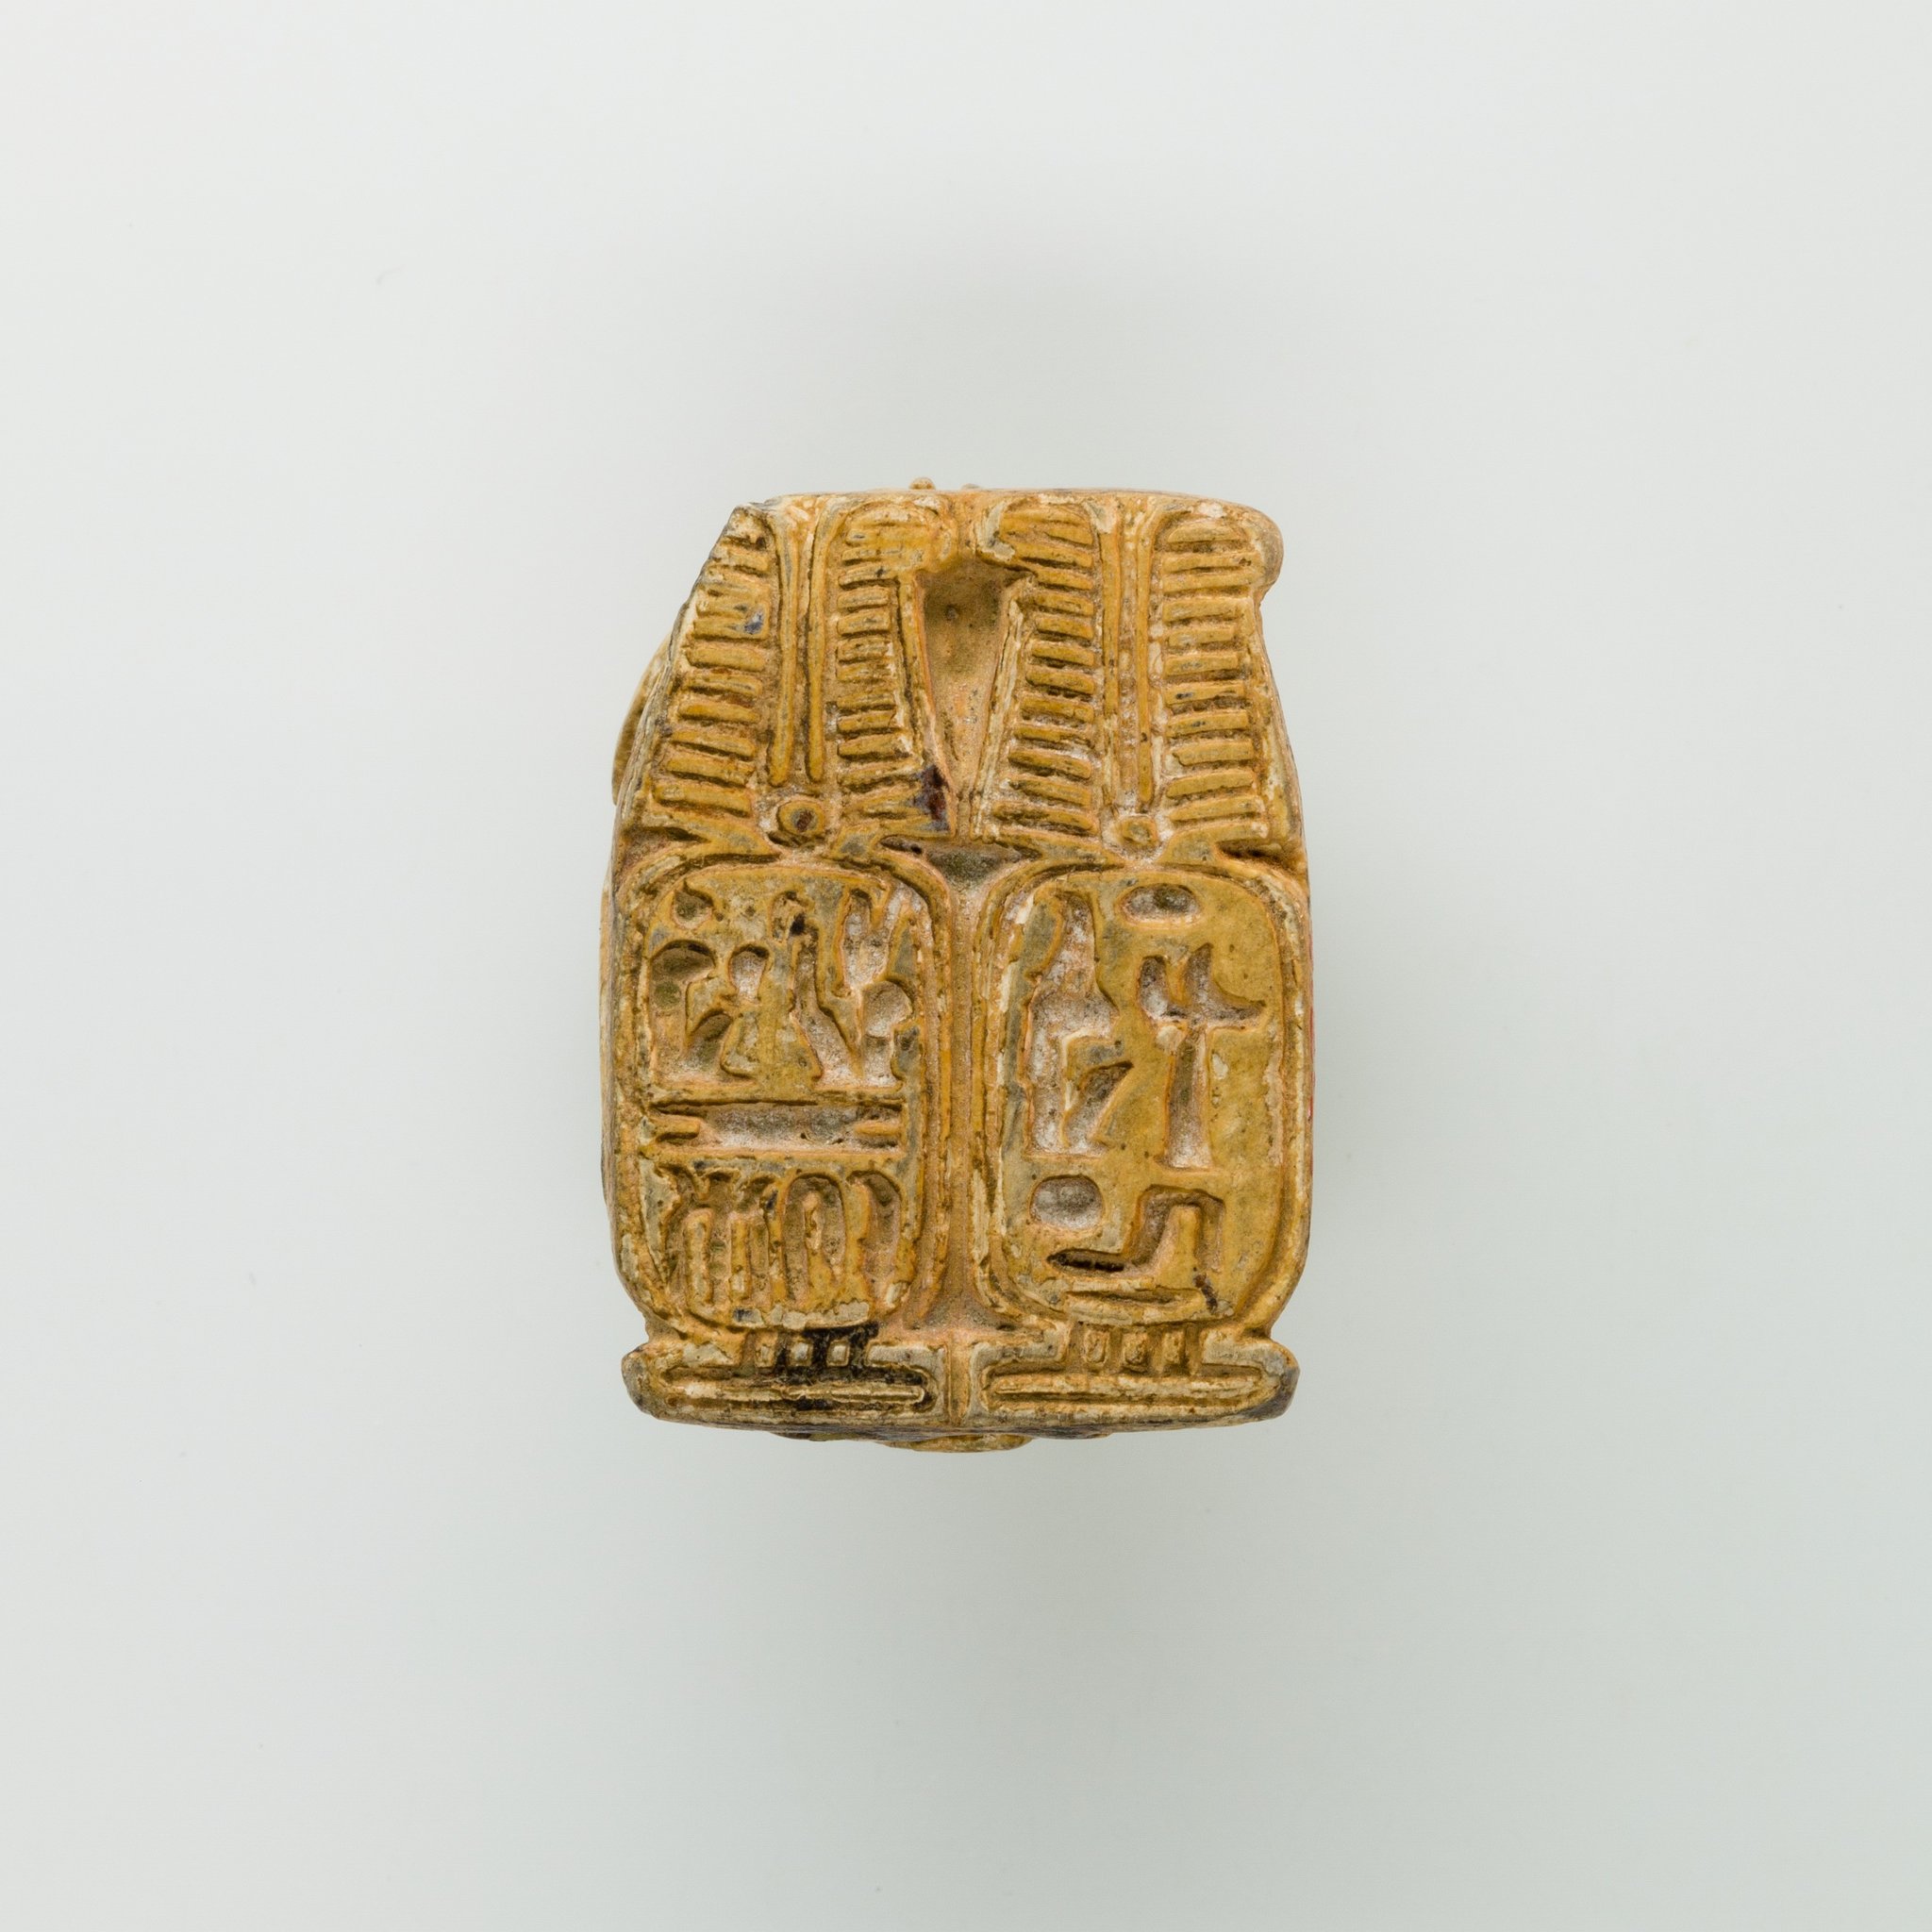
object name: scarab, ramesses ii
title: Scarab of Ramesses II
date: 1295-1070 BCE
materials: stone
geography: egypt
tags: hieroglyphs,scarabs